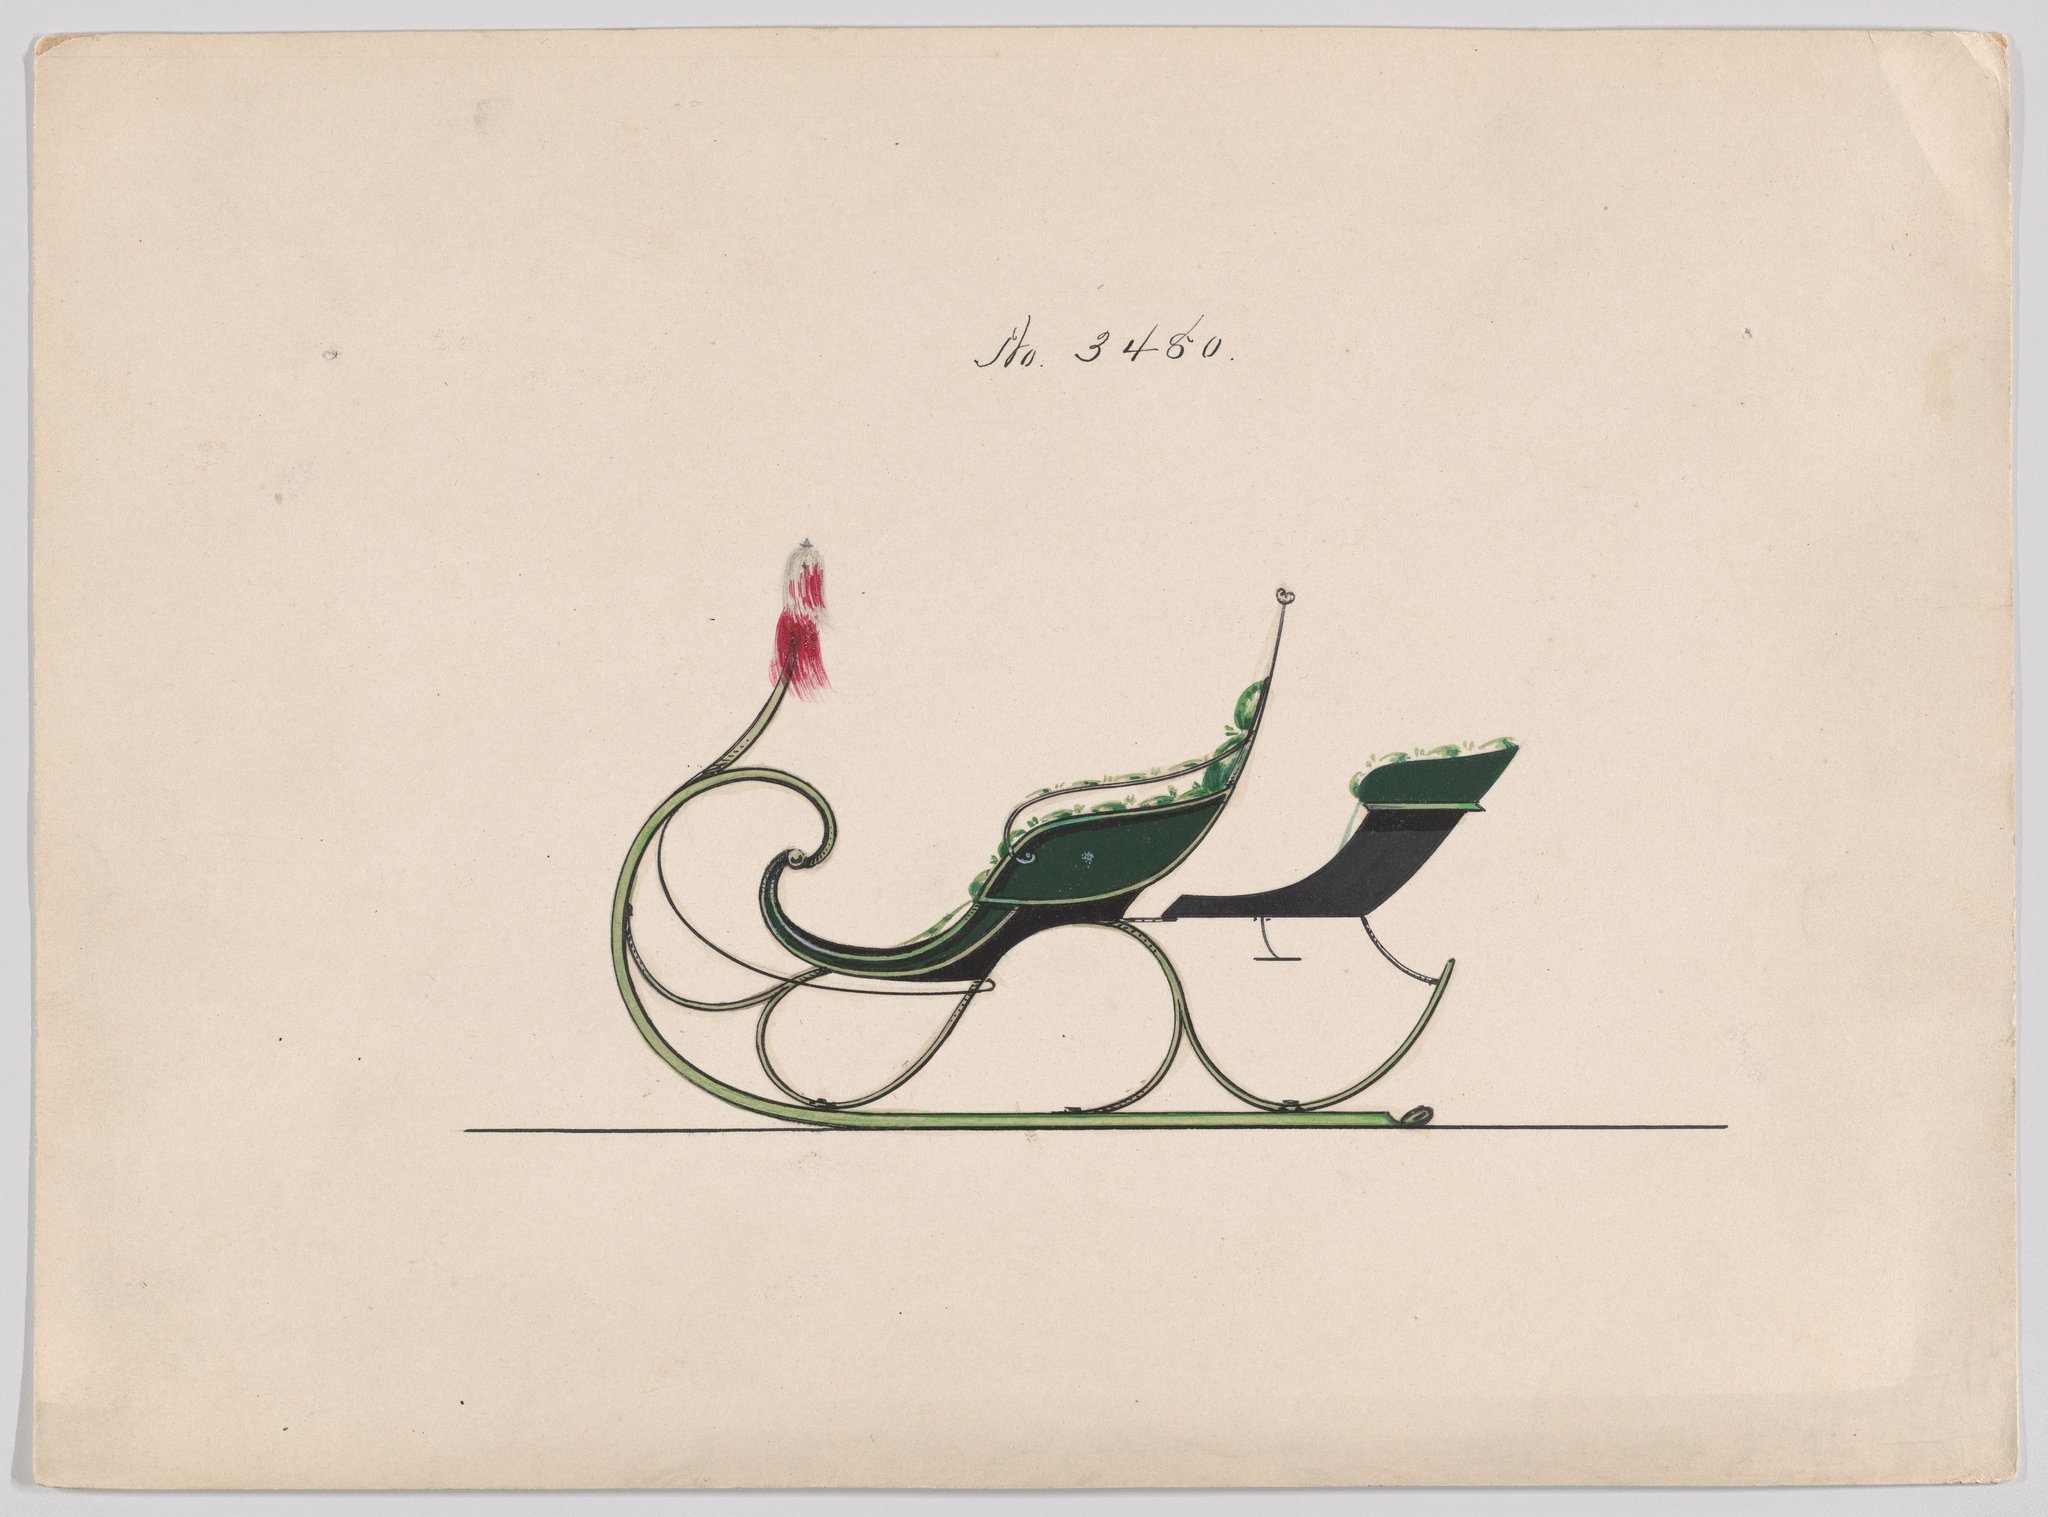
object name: drawing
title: Sleigh with Rumble Seat #3480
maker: brewster & co.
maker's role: manufacturer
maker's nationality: american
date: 1879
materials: gouache, gum arabic, ink, watercolor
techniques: pen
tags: sleighs